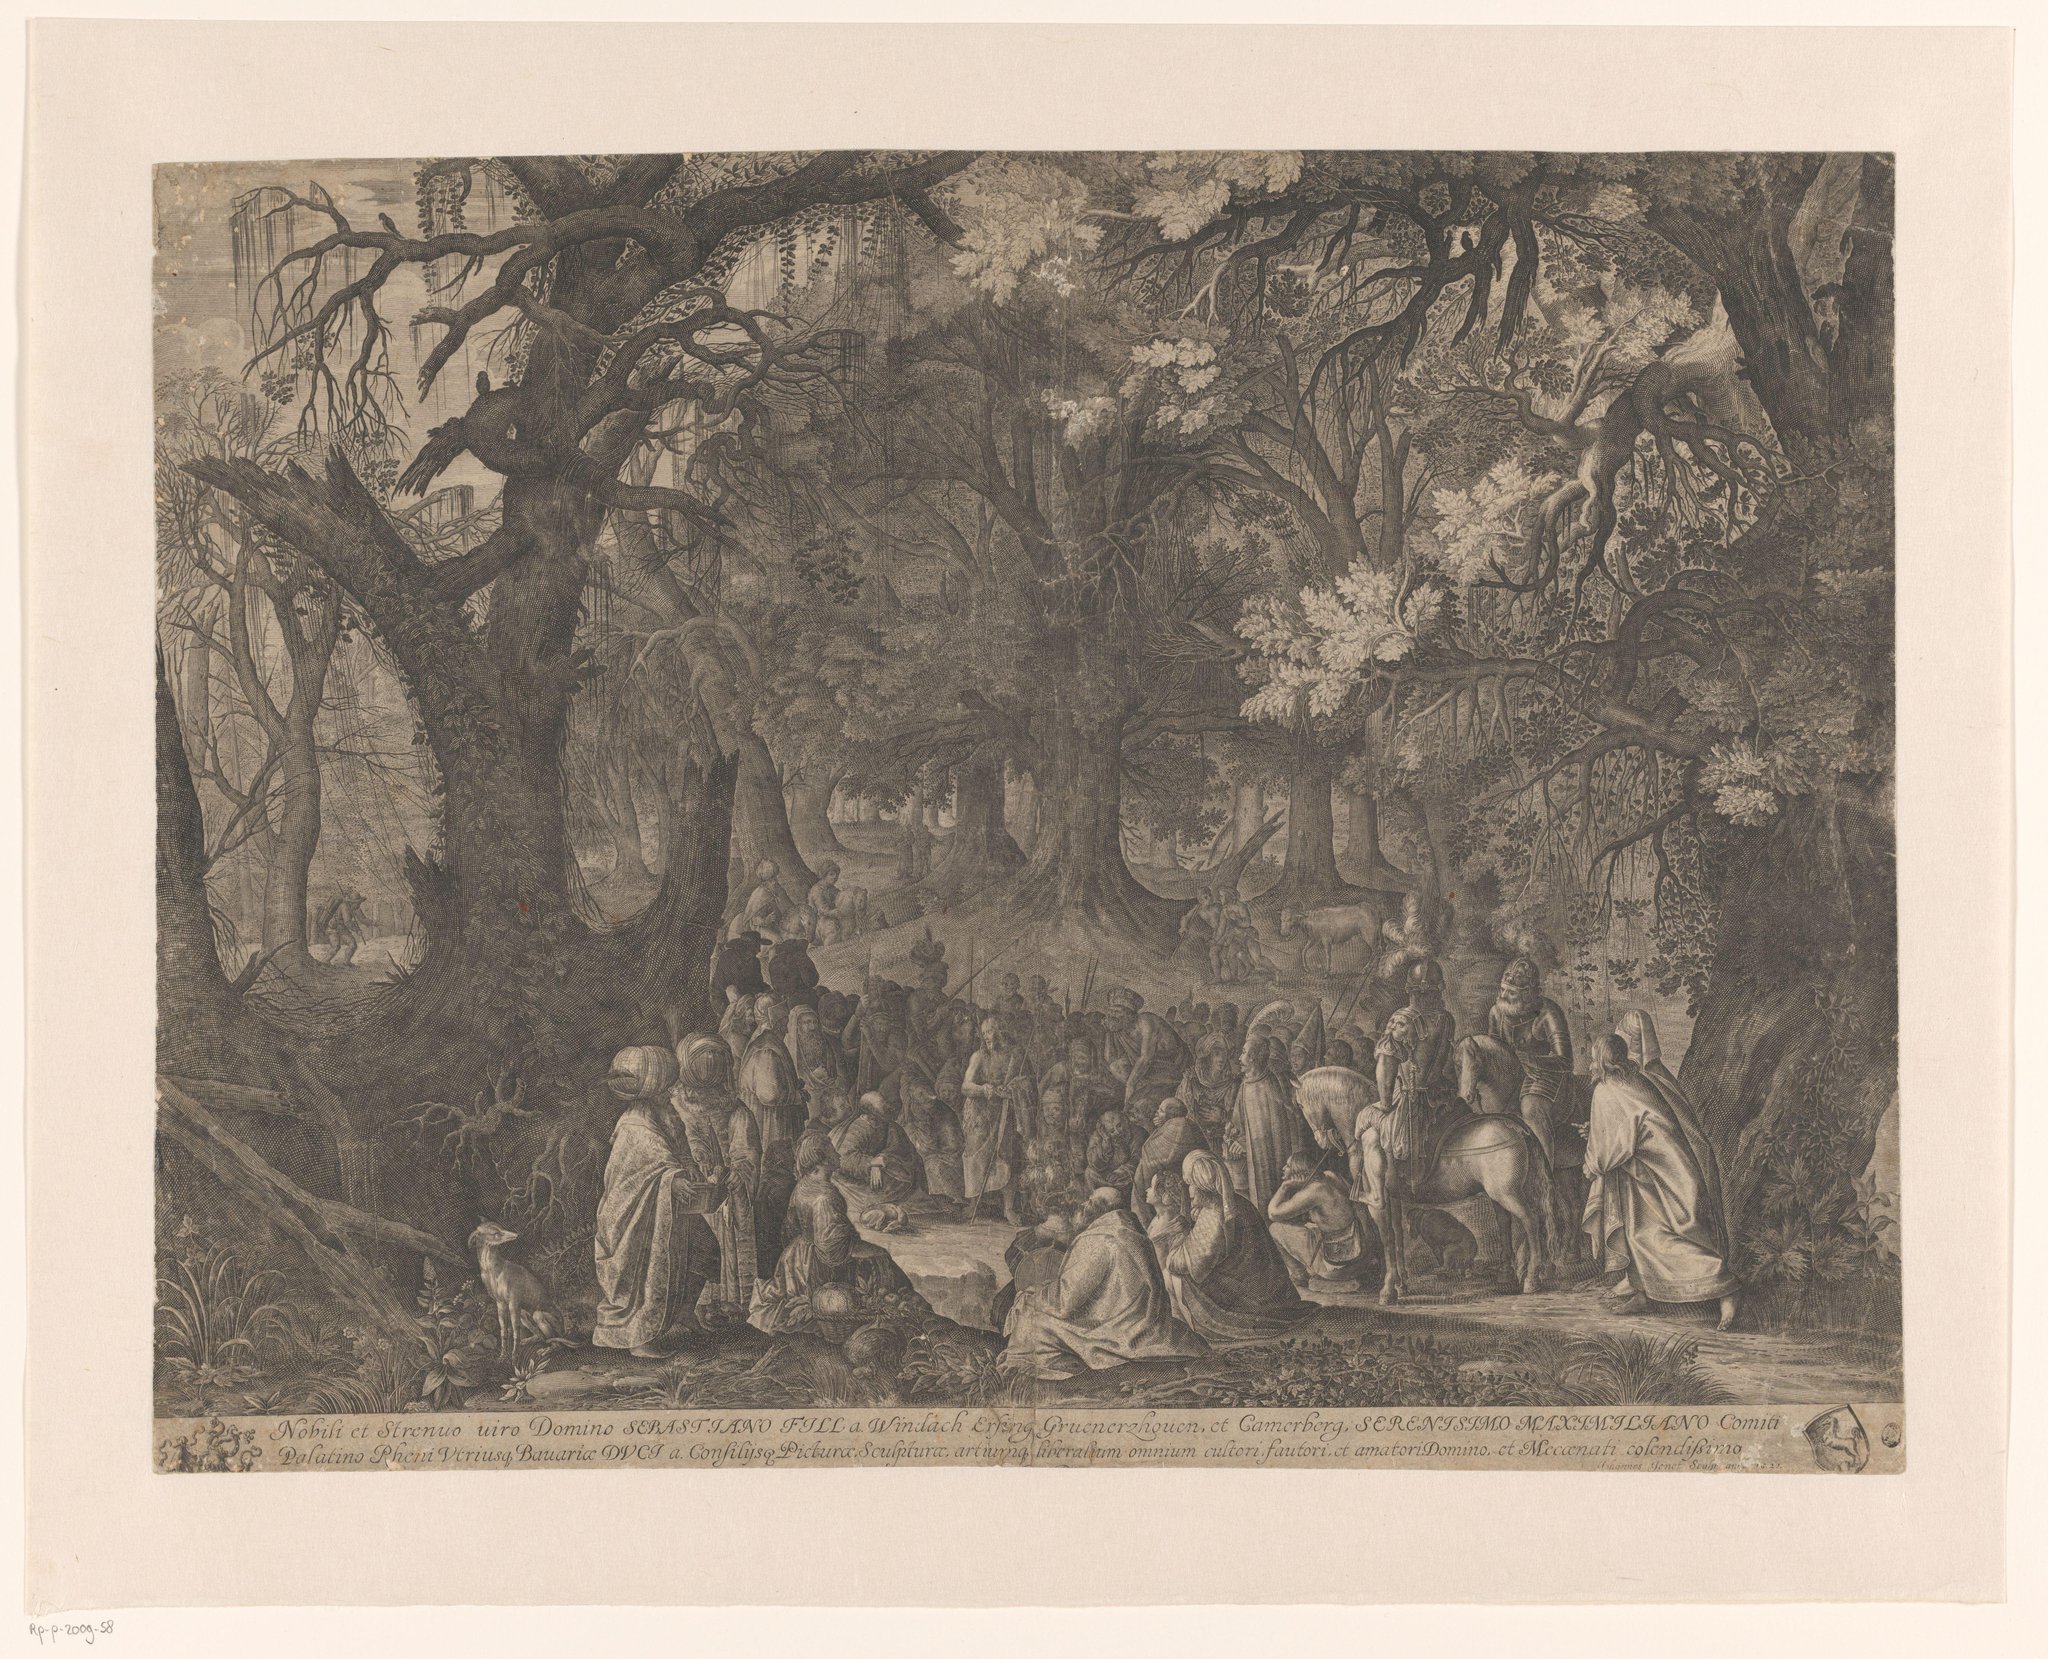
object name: print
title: Johannes de Doper preekt in het bos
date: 1621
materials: paper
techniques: engraving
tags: forest, wood, john the baptist preaching (perhaps christ among the bystanders), armorial bearing, heraldry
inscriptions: collector's mark: Lugt 2760, collector's mark, collector's mark: Lugt 2228